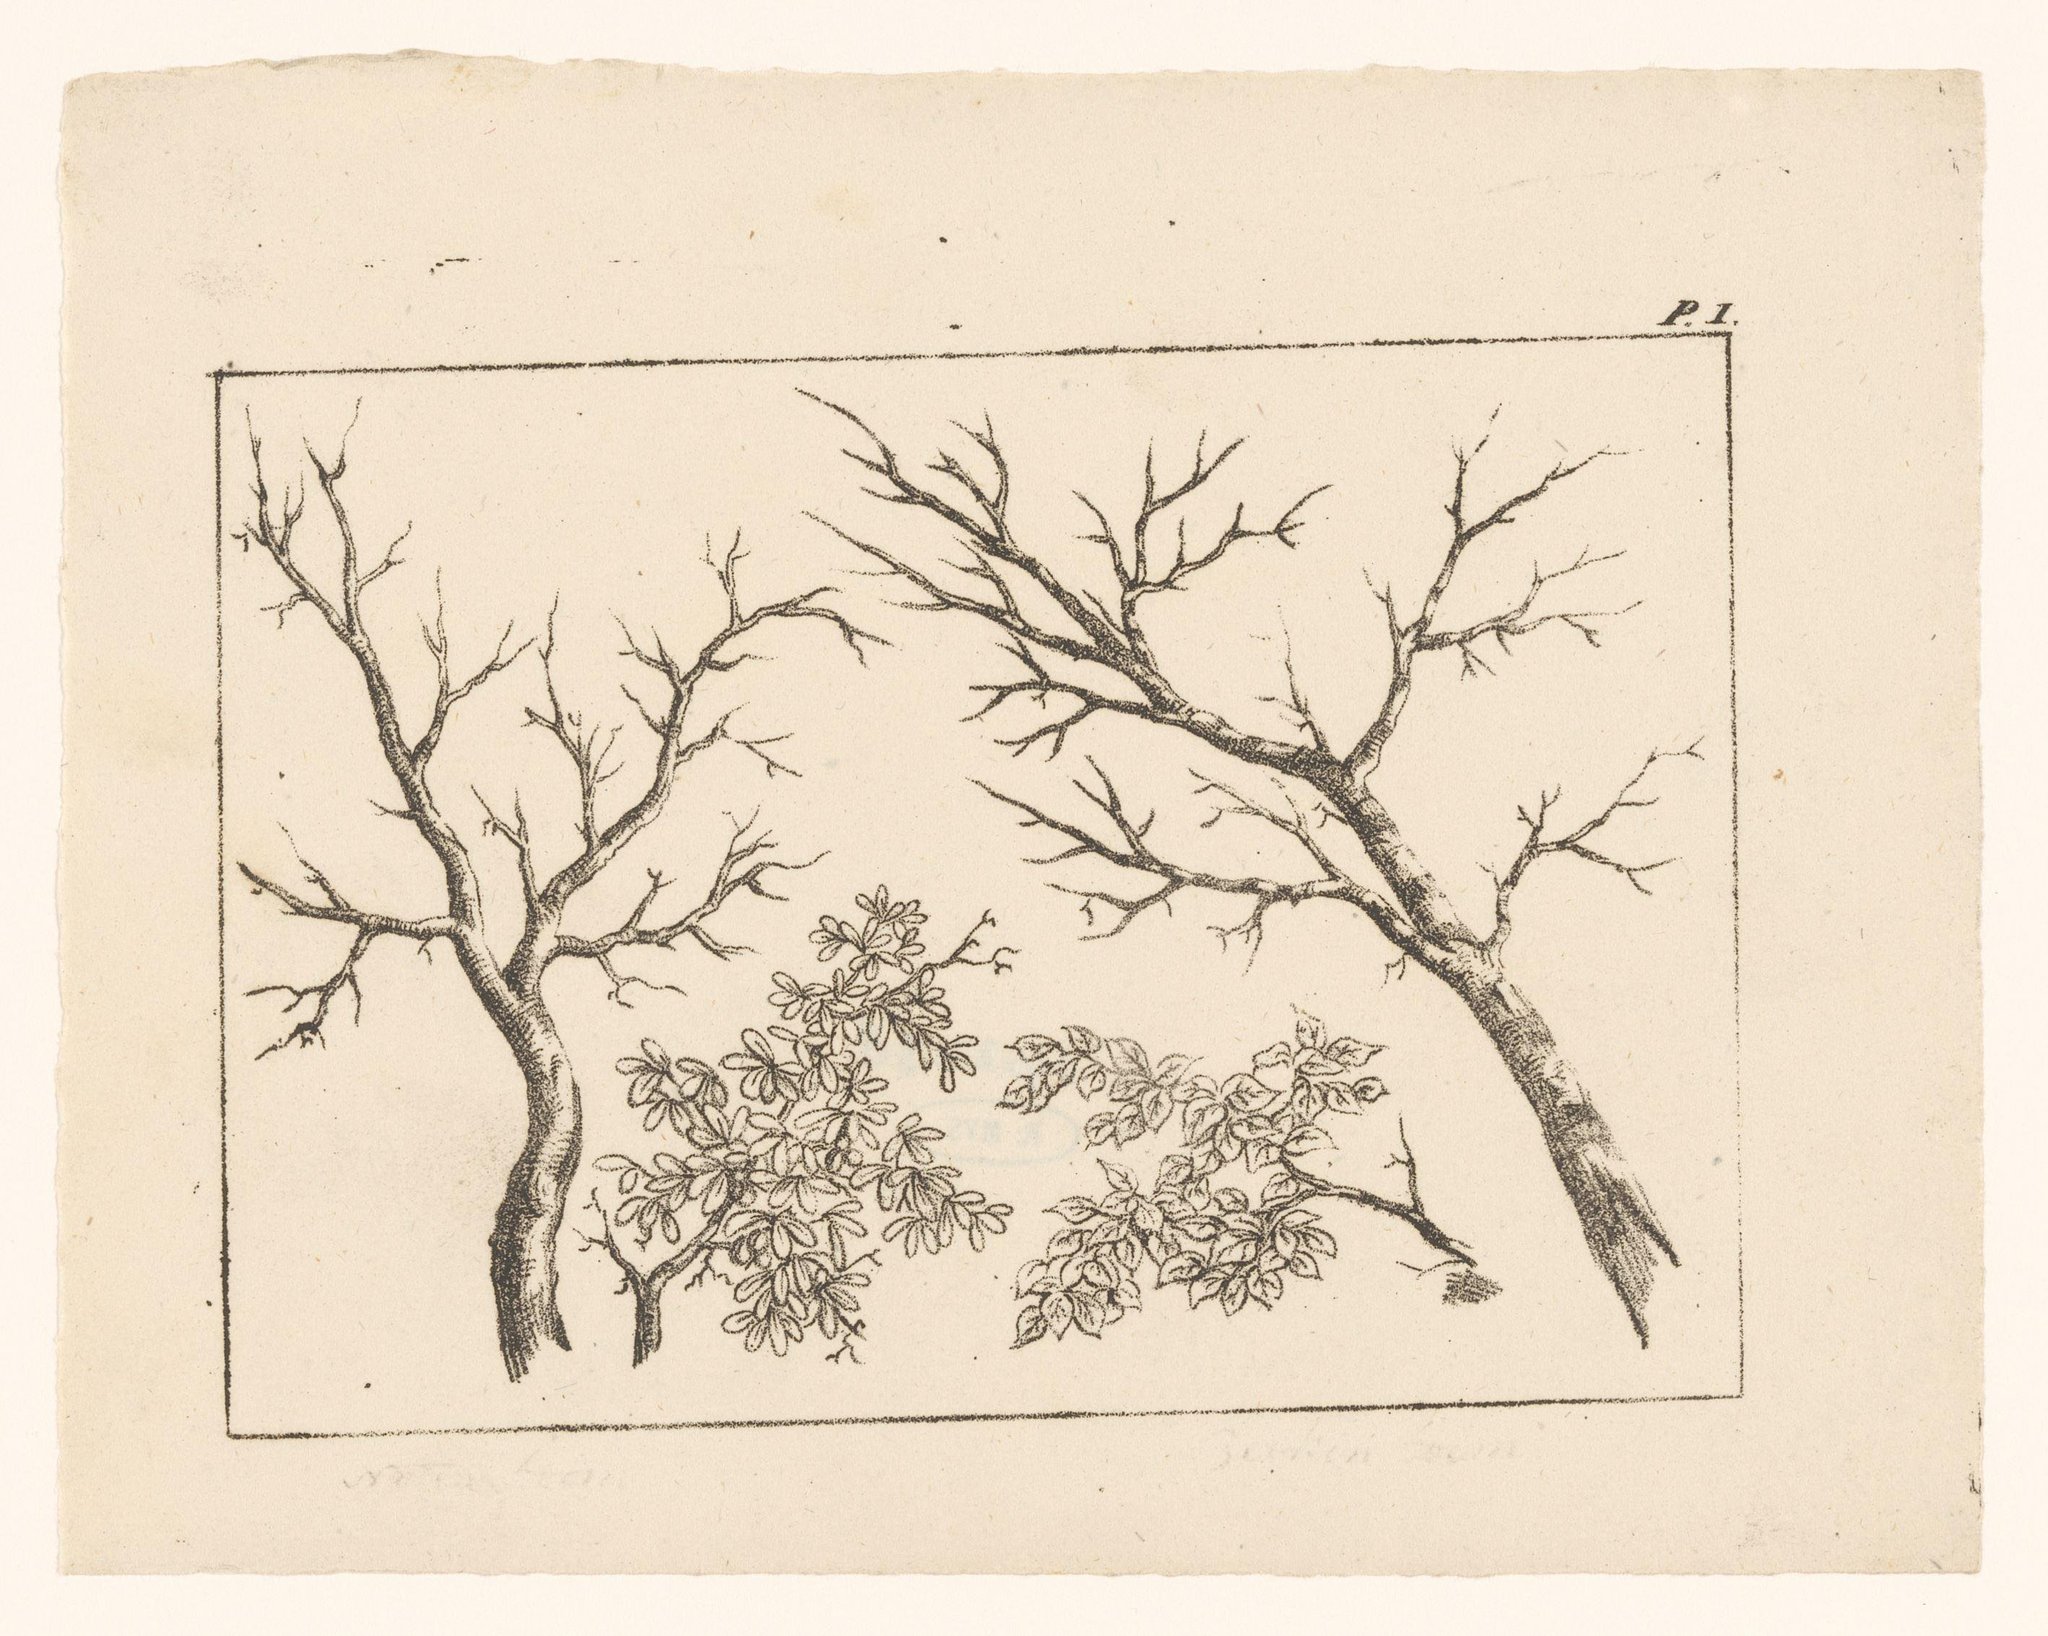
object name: print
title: Vier takken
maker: Anonymous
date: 1819-1837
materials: paper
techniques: lithograph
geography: netherlands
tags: trees (+ branch, stick)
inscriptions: inscription: ‘Noten boom’, collector's mark: ‘Noten boom [...]’ Lugt 2228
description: De takken links en rechts zijn kaal, de twee kleinere takken in het midden dragen blad. Genummerd rechtsboven: P. 1.